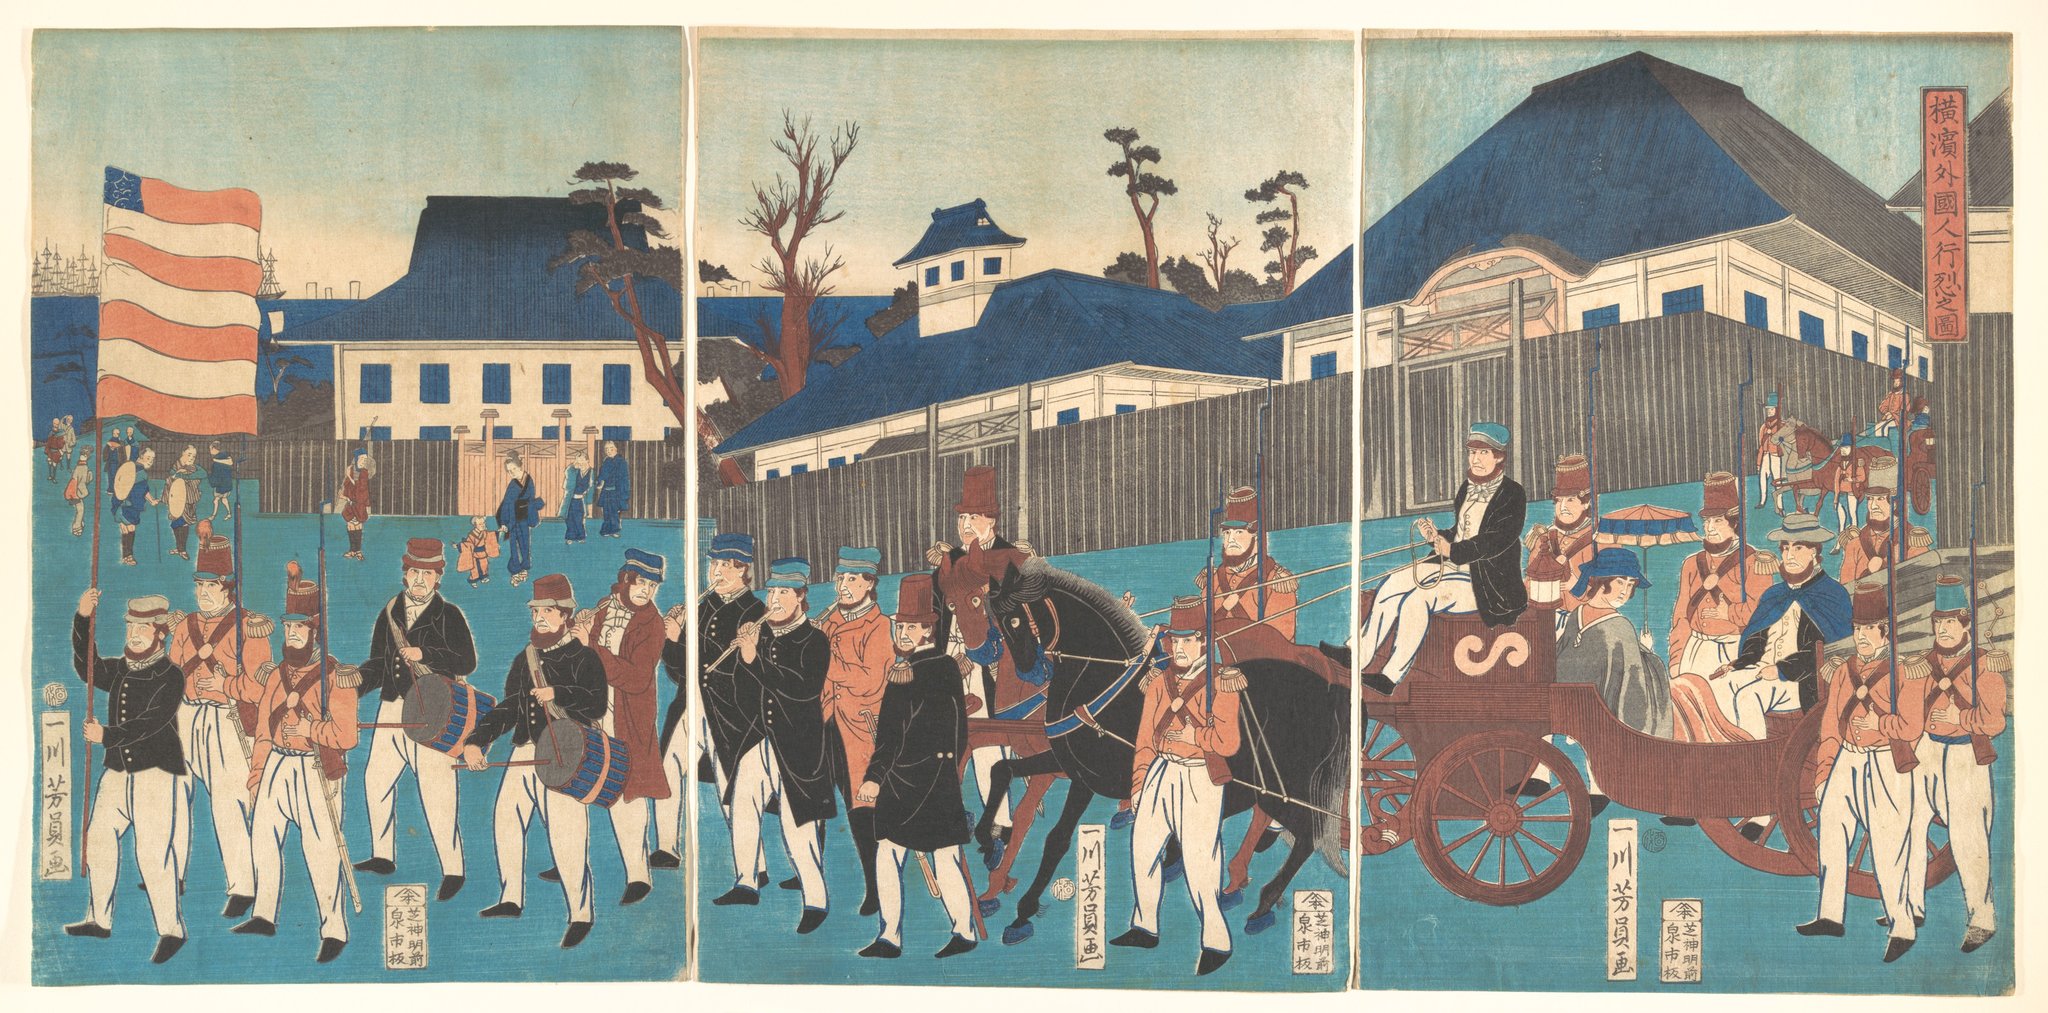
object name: print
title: Picture of a Procession of Foreigners at Yokohama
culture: japanese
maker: utagawa yoshikazu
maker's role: artist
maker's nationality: japanese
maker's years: 1845-1870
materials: ink, paper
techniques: woodblock print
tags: musical instruments,houses,men,flags,carriages